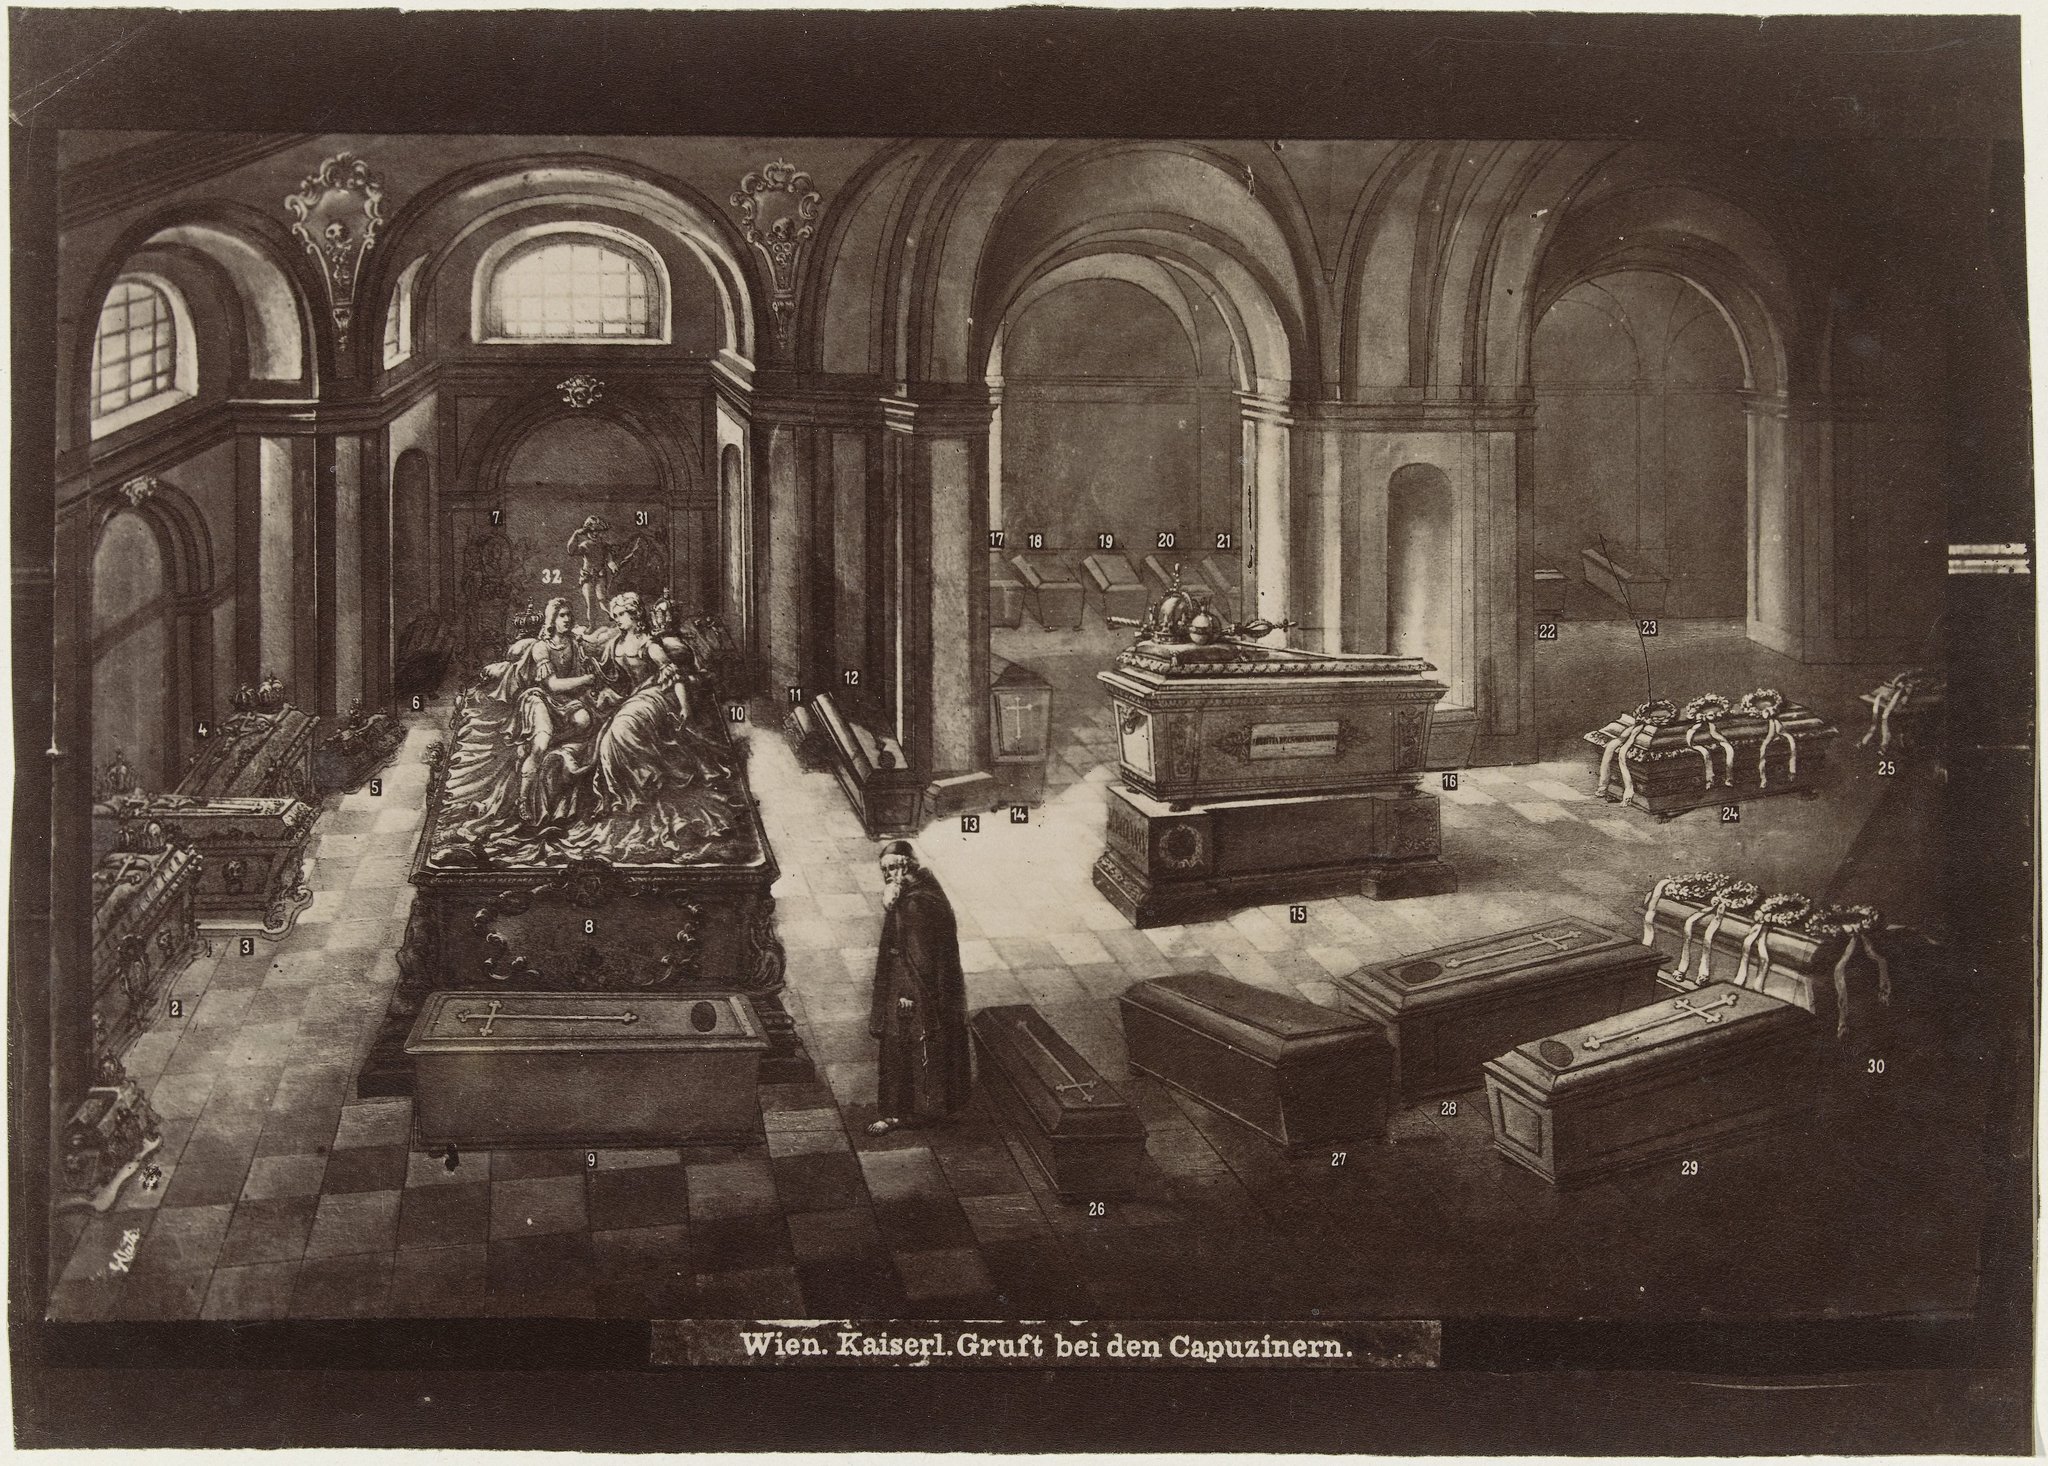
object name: reproduction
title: Kaiserl. Gruft bei den Capuzinern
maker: Anonymous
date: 1851-1900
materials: cardboard, paper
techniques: albumen print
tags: drawing, catacombs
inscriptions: number